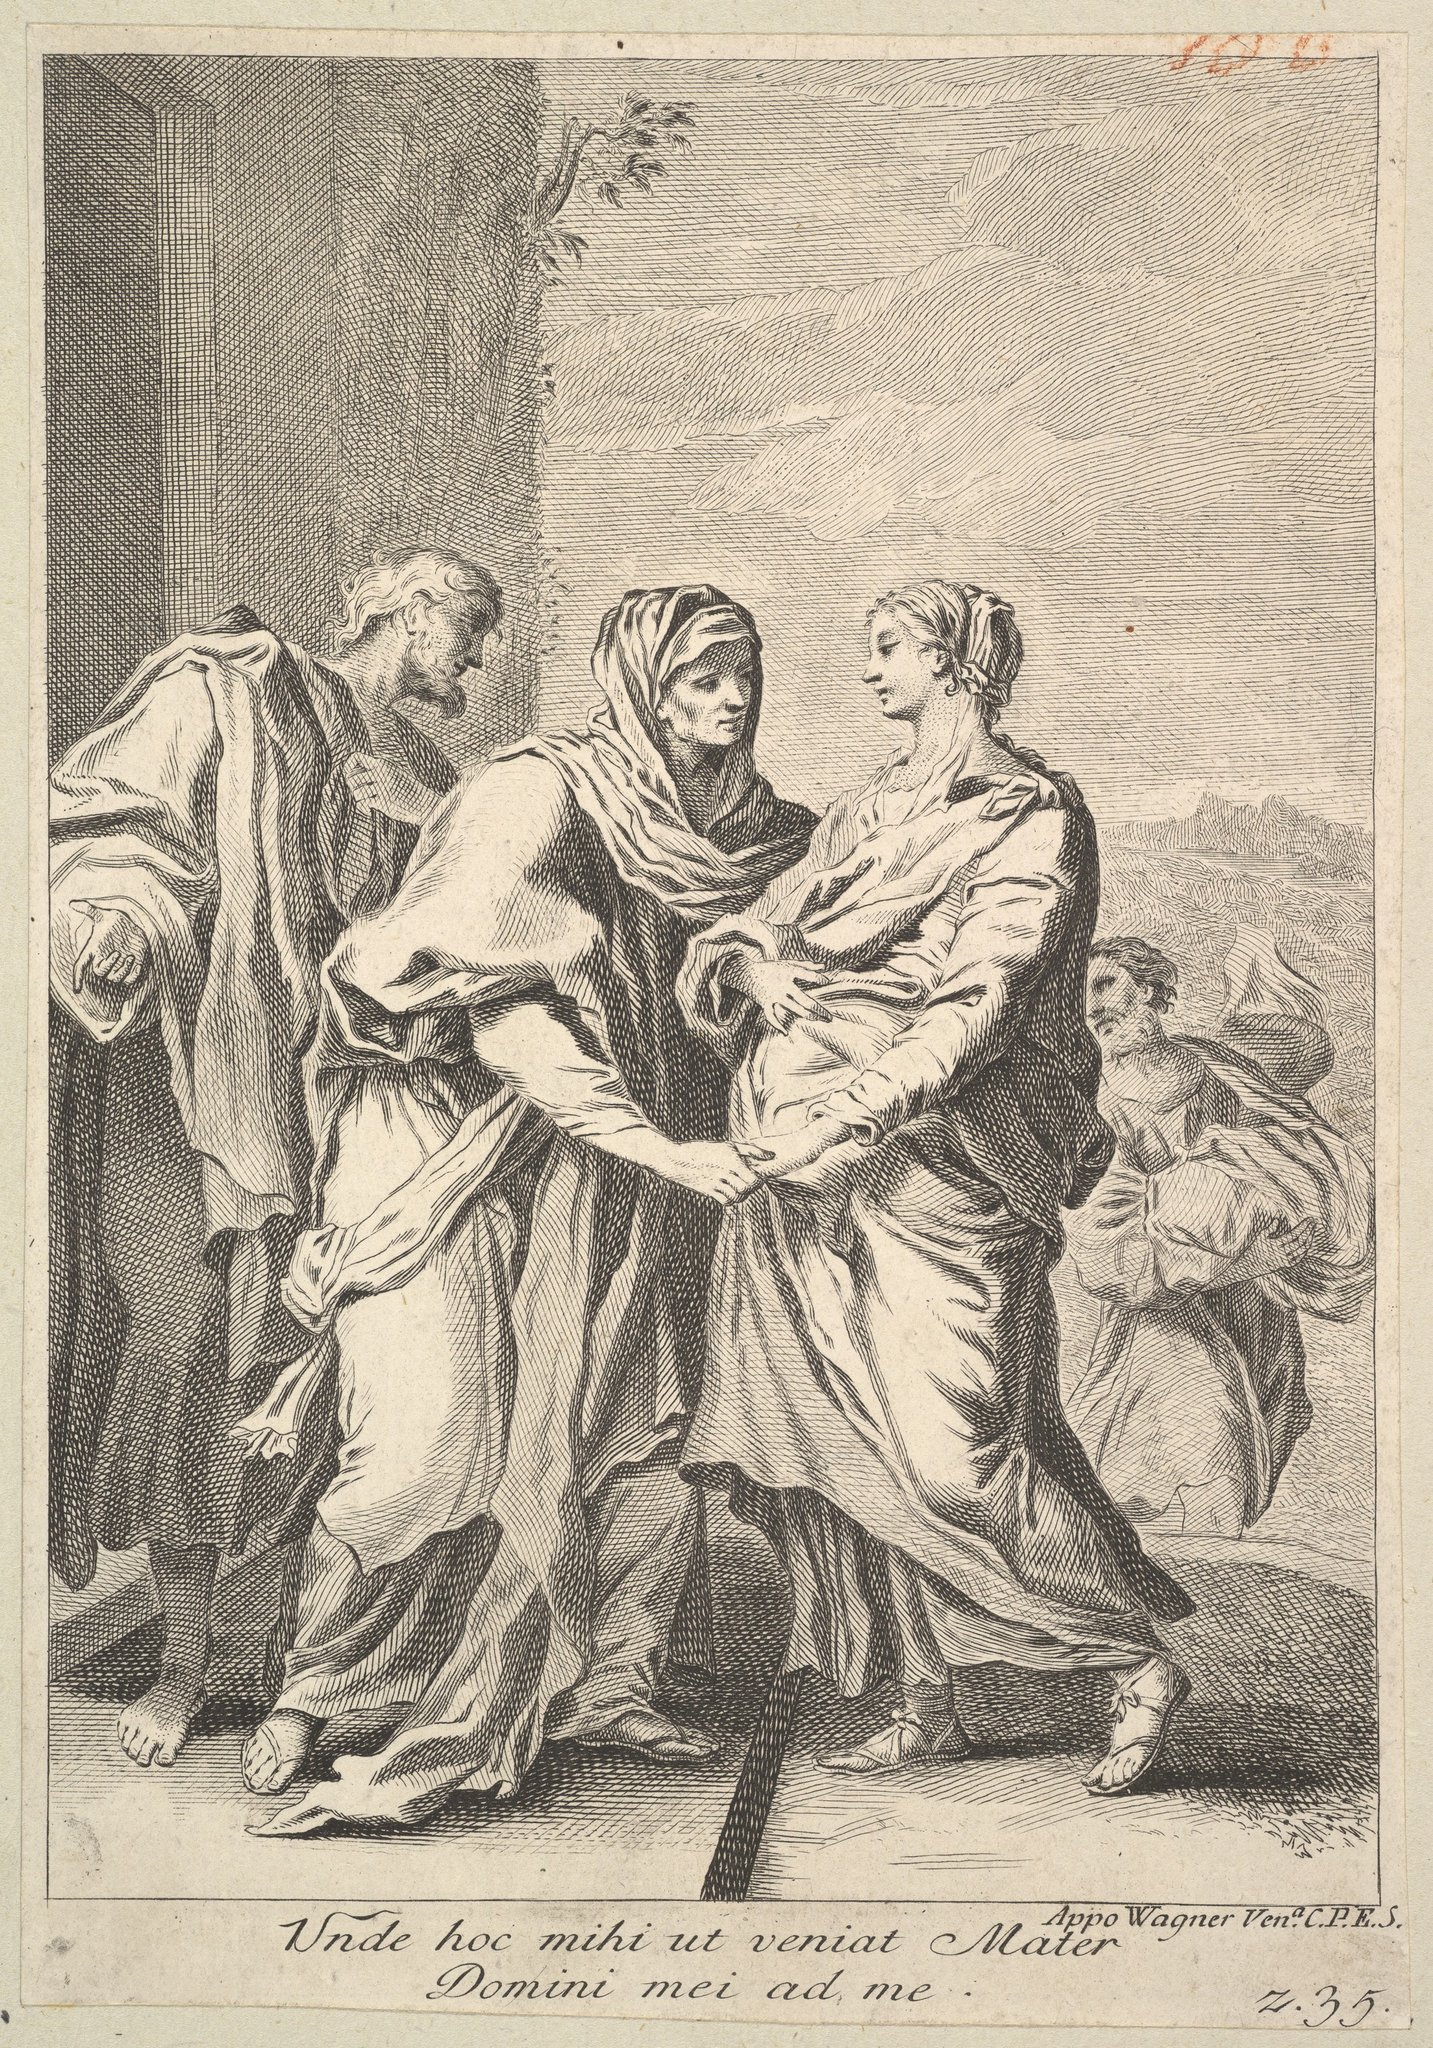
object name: print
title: Visitation (copy in reverse)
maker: joseph wagner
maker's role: artist and publisher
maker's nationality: italian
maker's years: 1706-1780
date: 1706-1780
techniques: engraving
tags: men,women,virgin mary